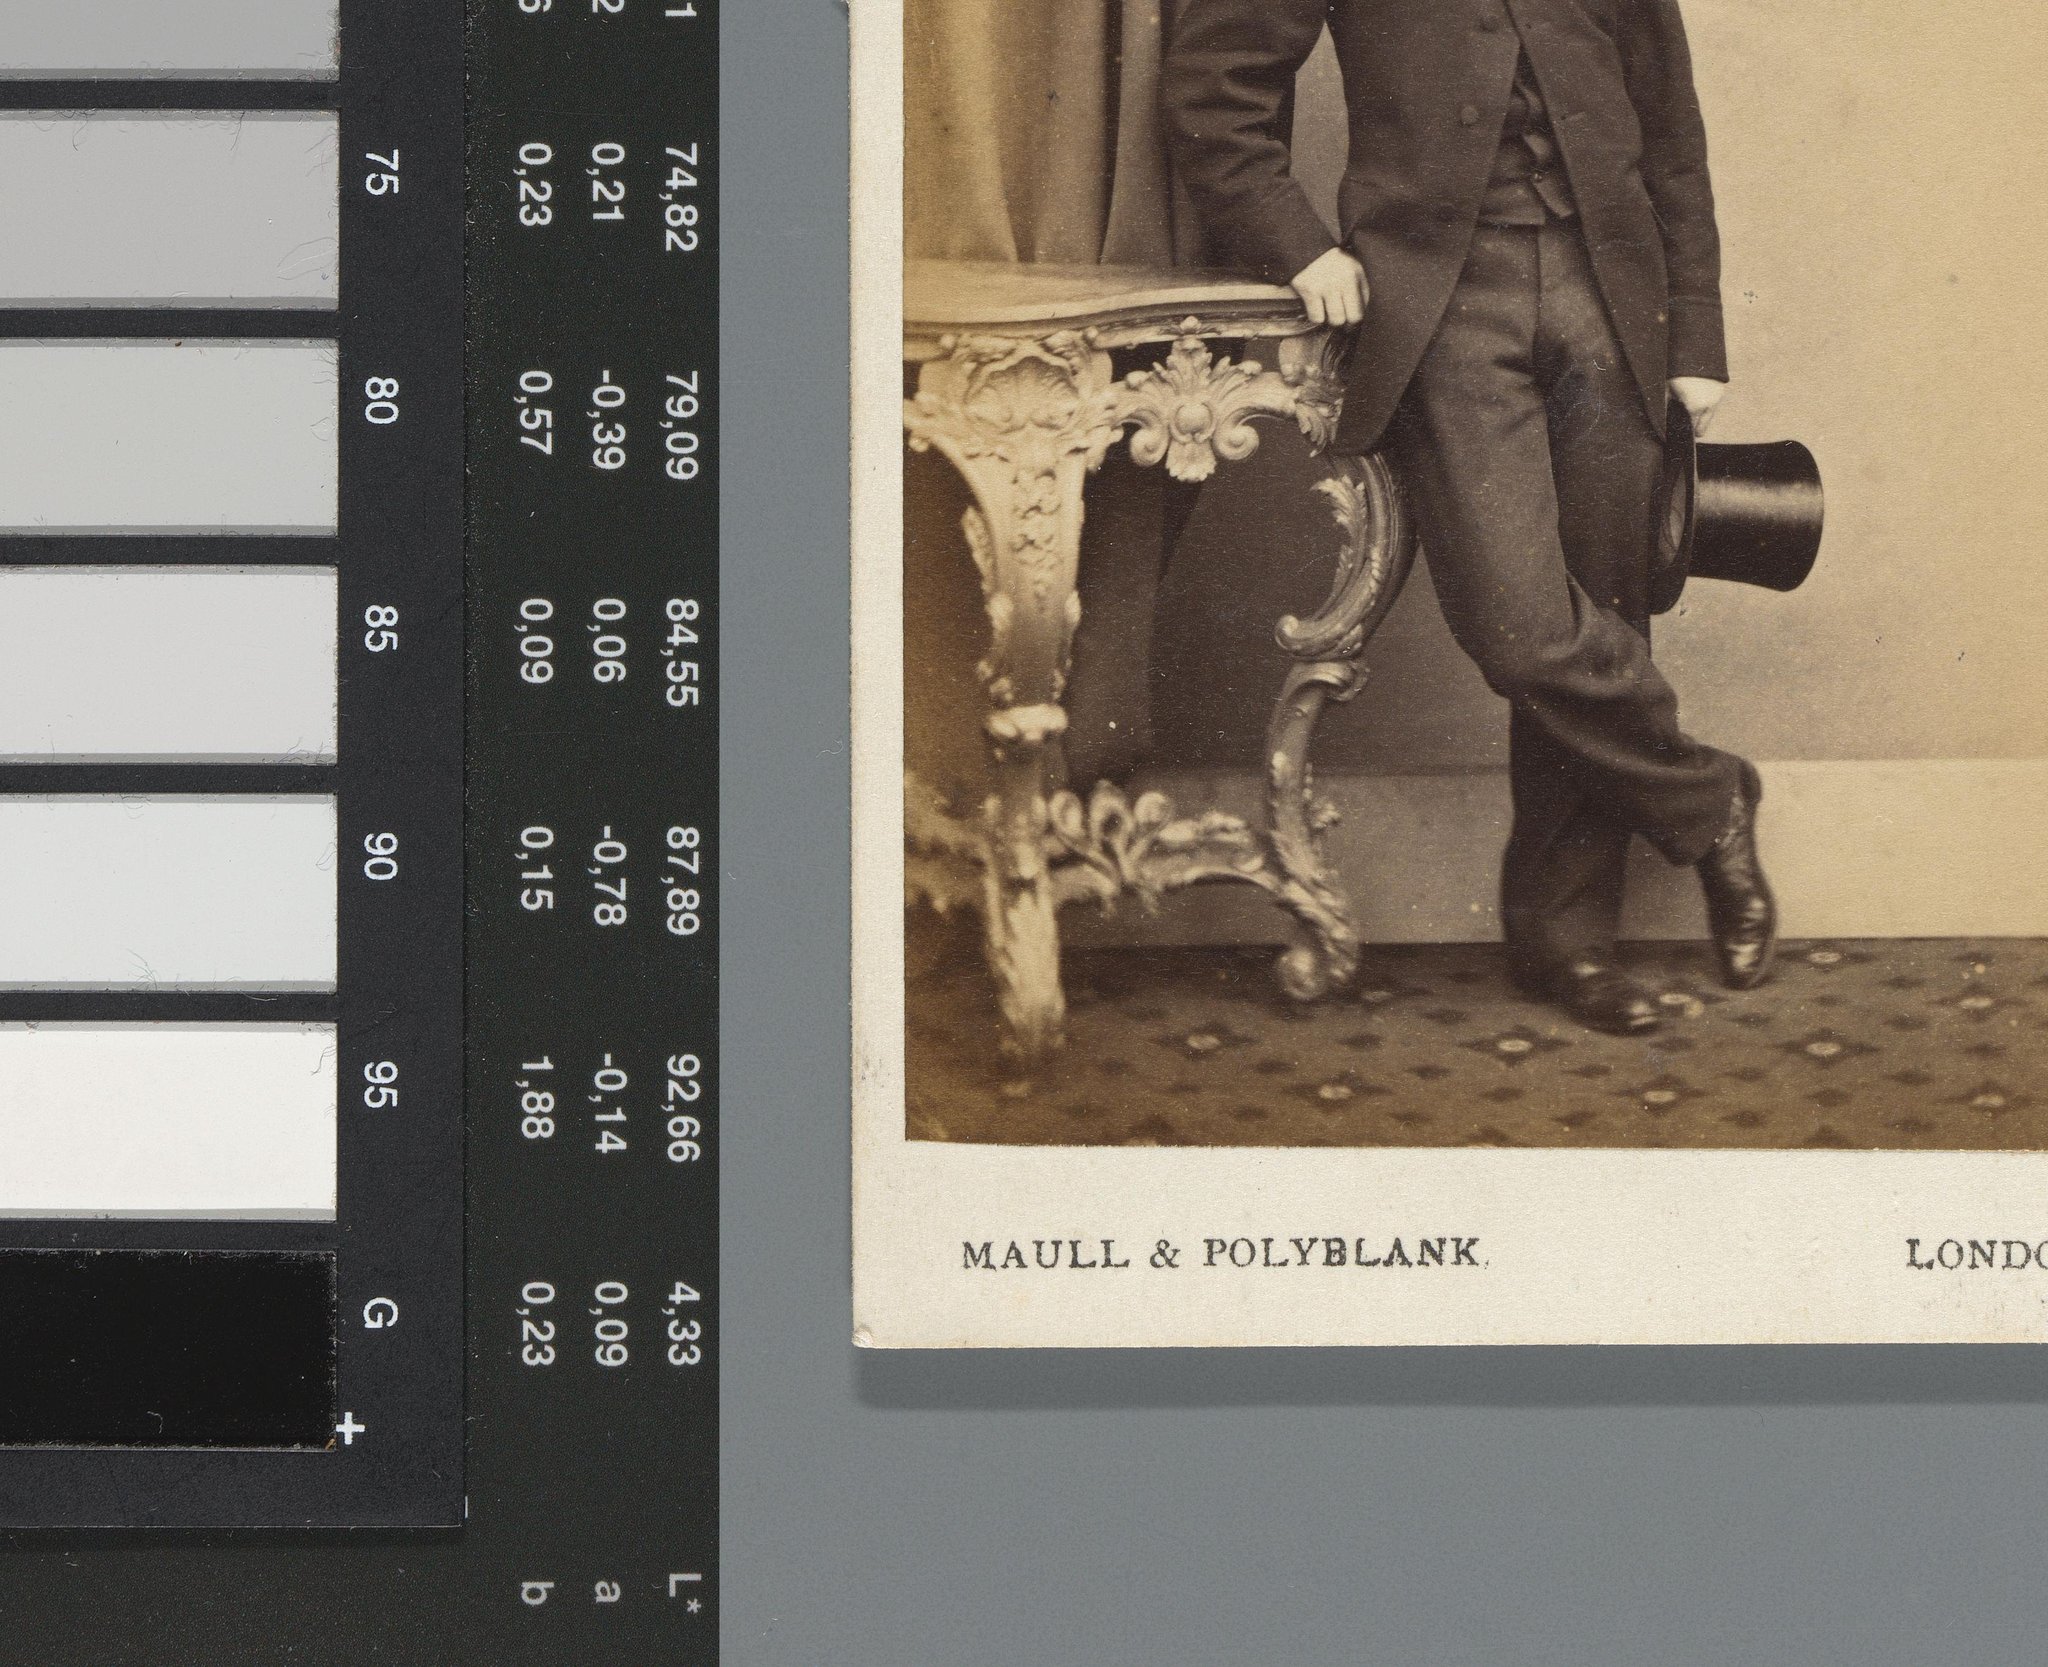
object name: carte de visite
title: Portret van een jonge man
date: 1860-1865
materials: photographic support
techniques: albumen print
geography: london